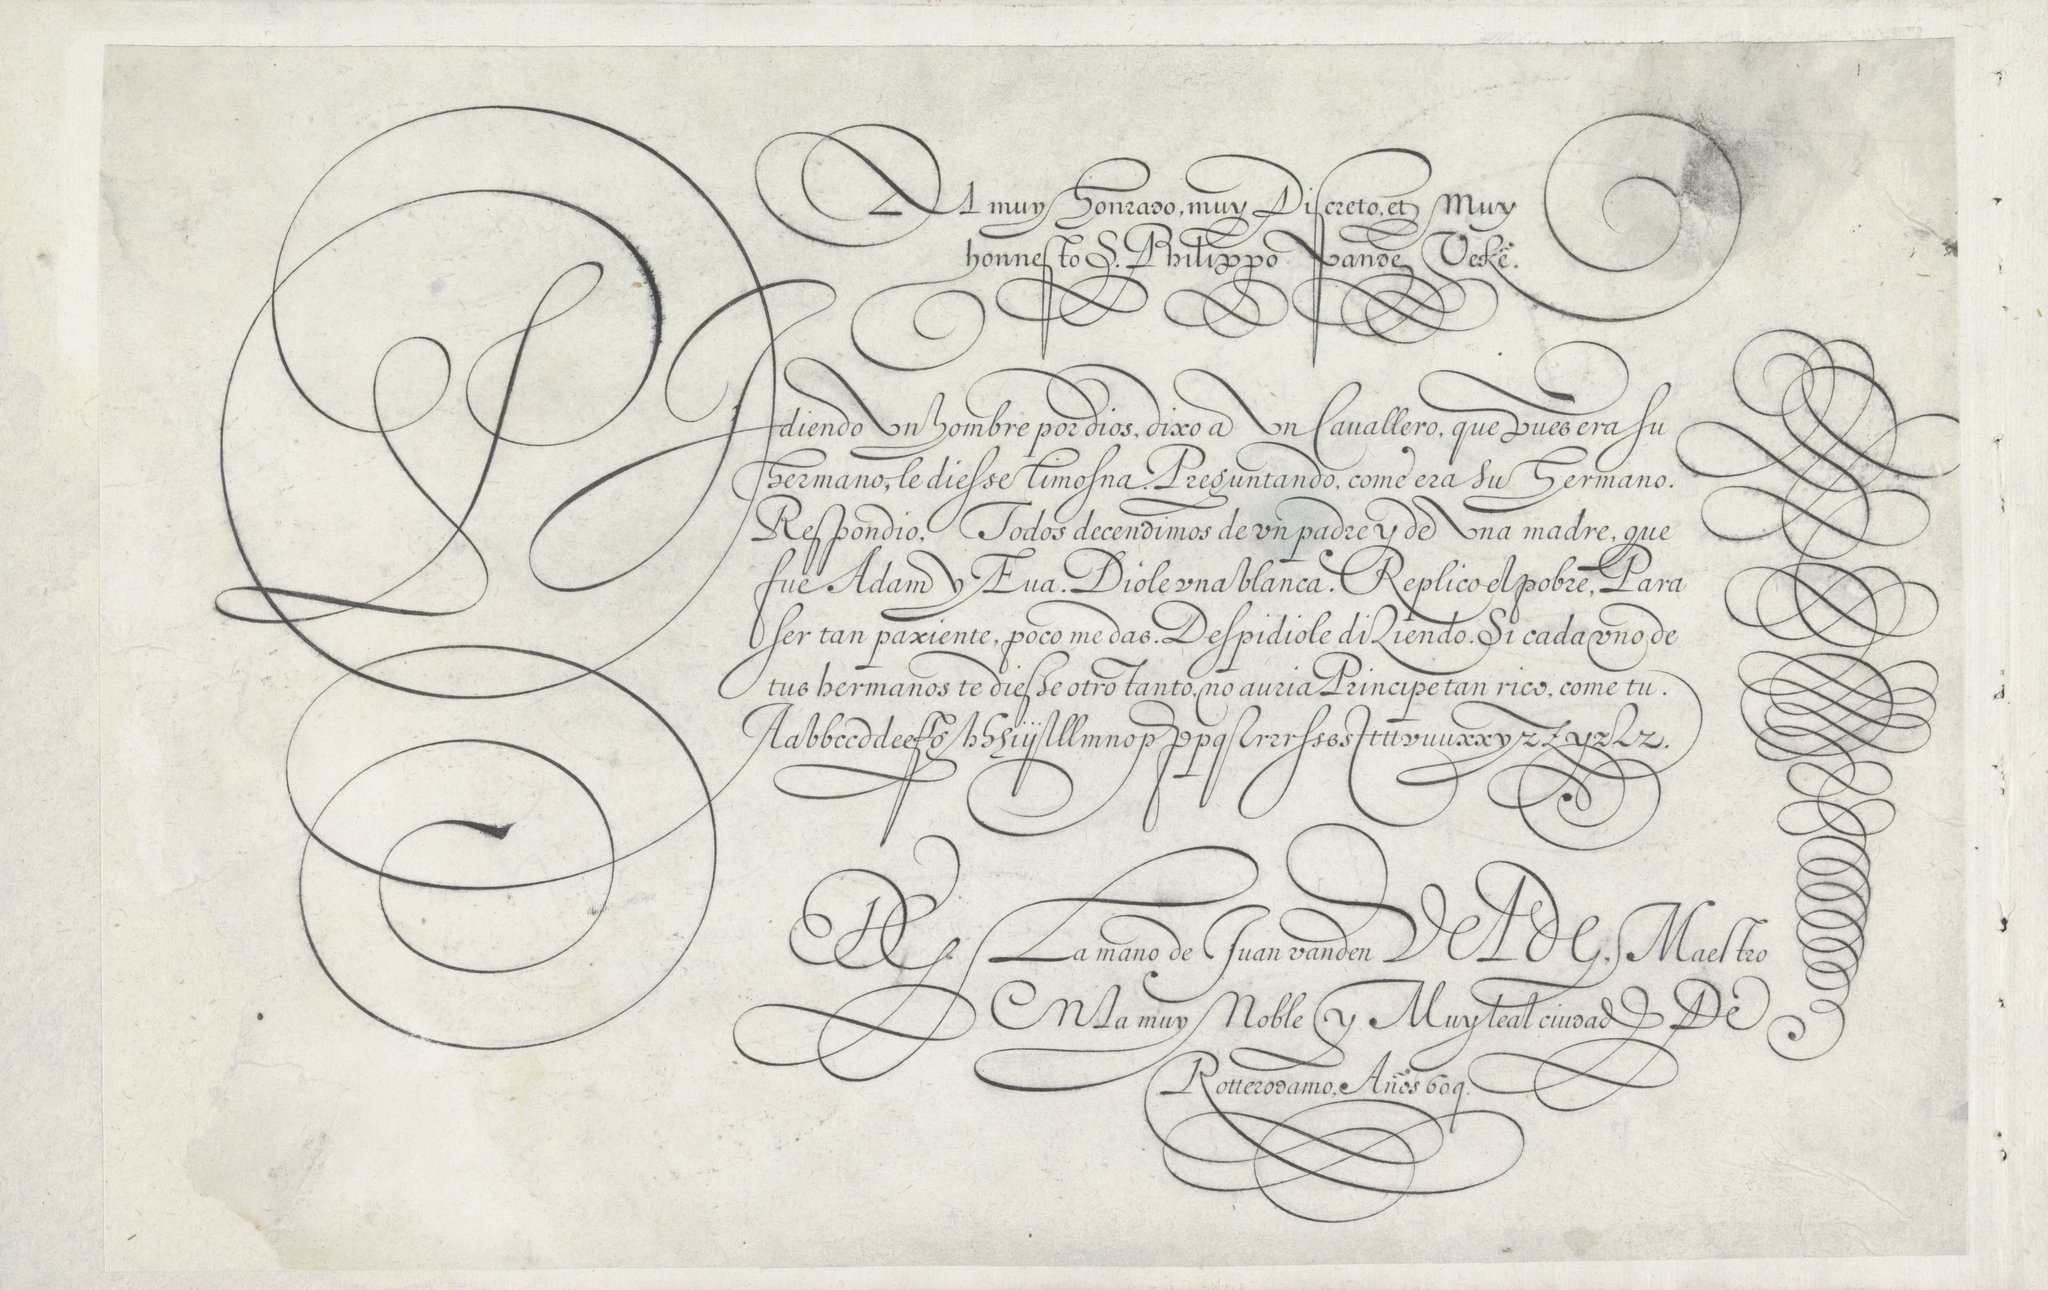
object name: album leaf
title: Spieghel der schrijfkonste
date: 1609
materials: ink, paper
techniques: calligraphy, pen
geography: rotterdam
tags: calligraphy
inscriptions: date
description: Kalligrafische tekening met de aanhef: Al muy honrado, muy discreto et muy honnesto, S. Philippo vande Veke(n). Daaronder zeven regels tekst in het Spaans: Pidiendo un hombre ... De tekst eindigt met eeb onderkastalfabet in dezelfde hand en is ondertekend: DG La mano de Juan vanden Velde ... Rechts krulwerk. De tekening maakt deel uit van een album.